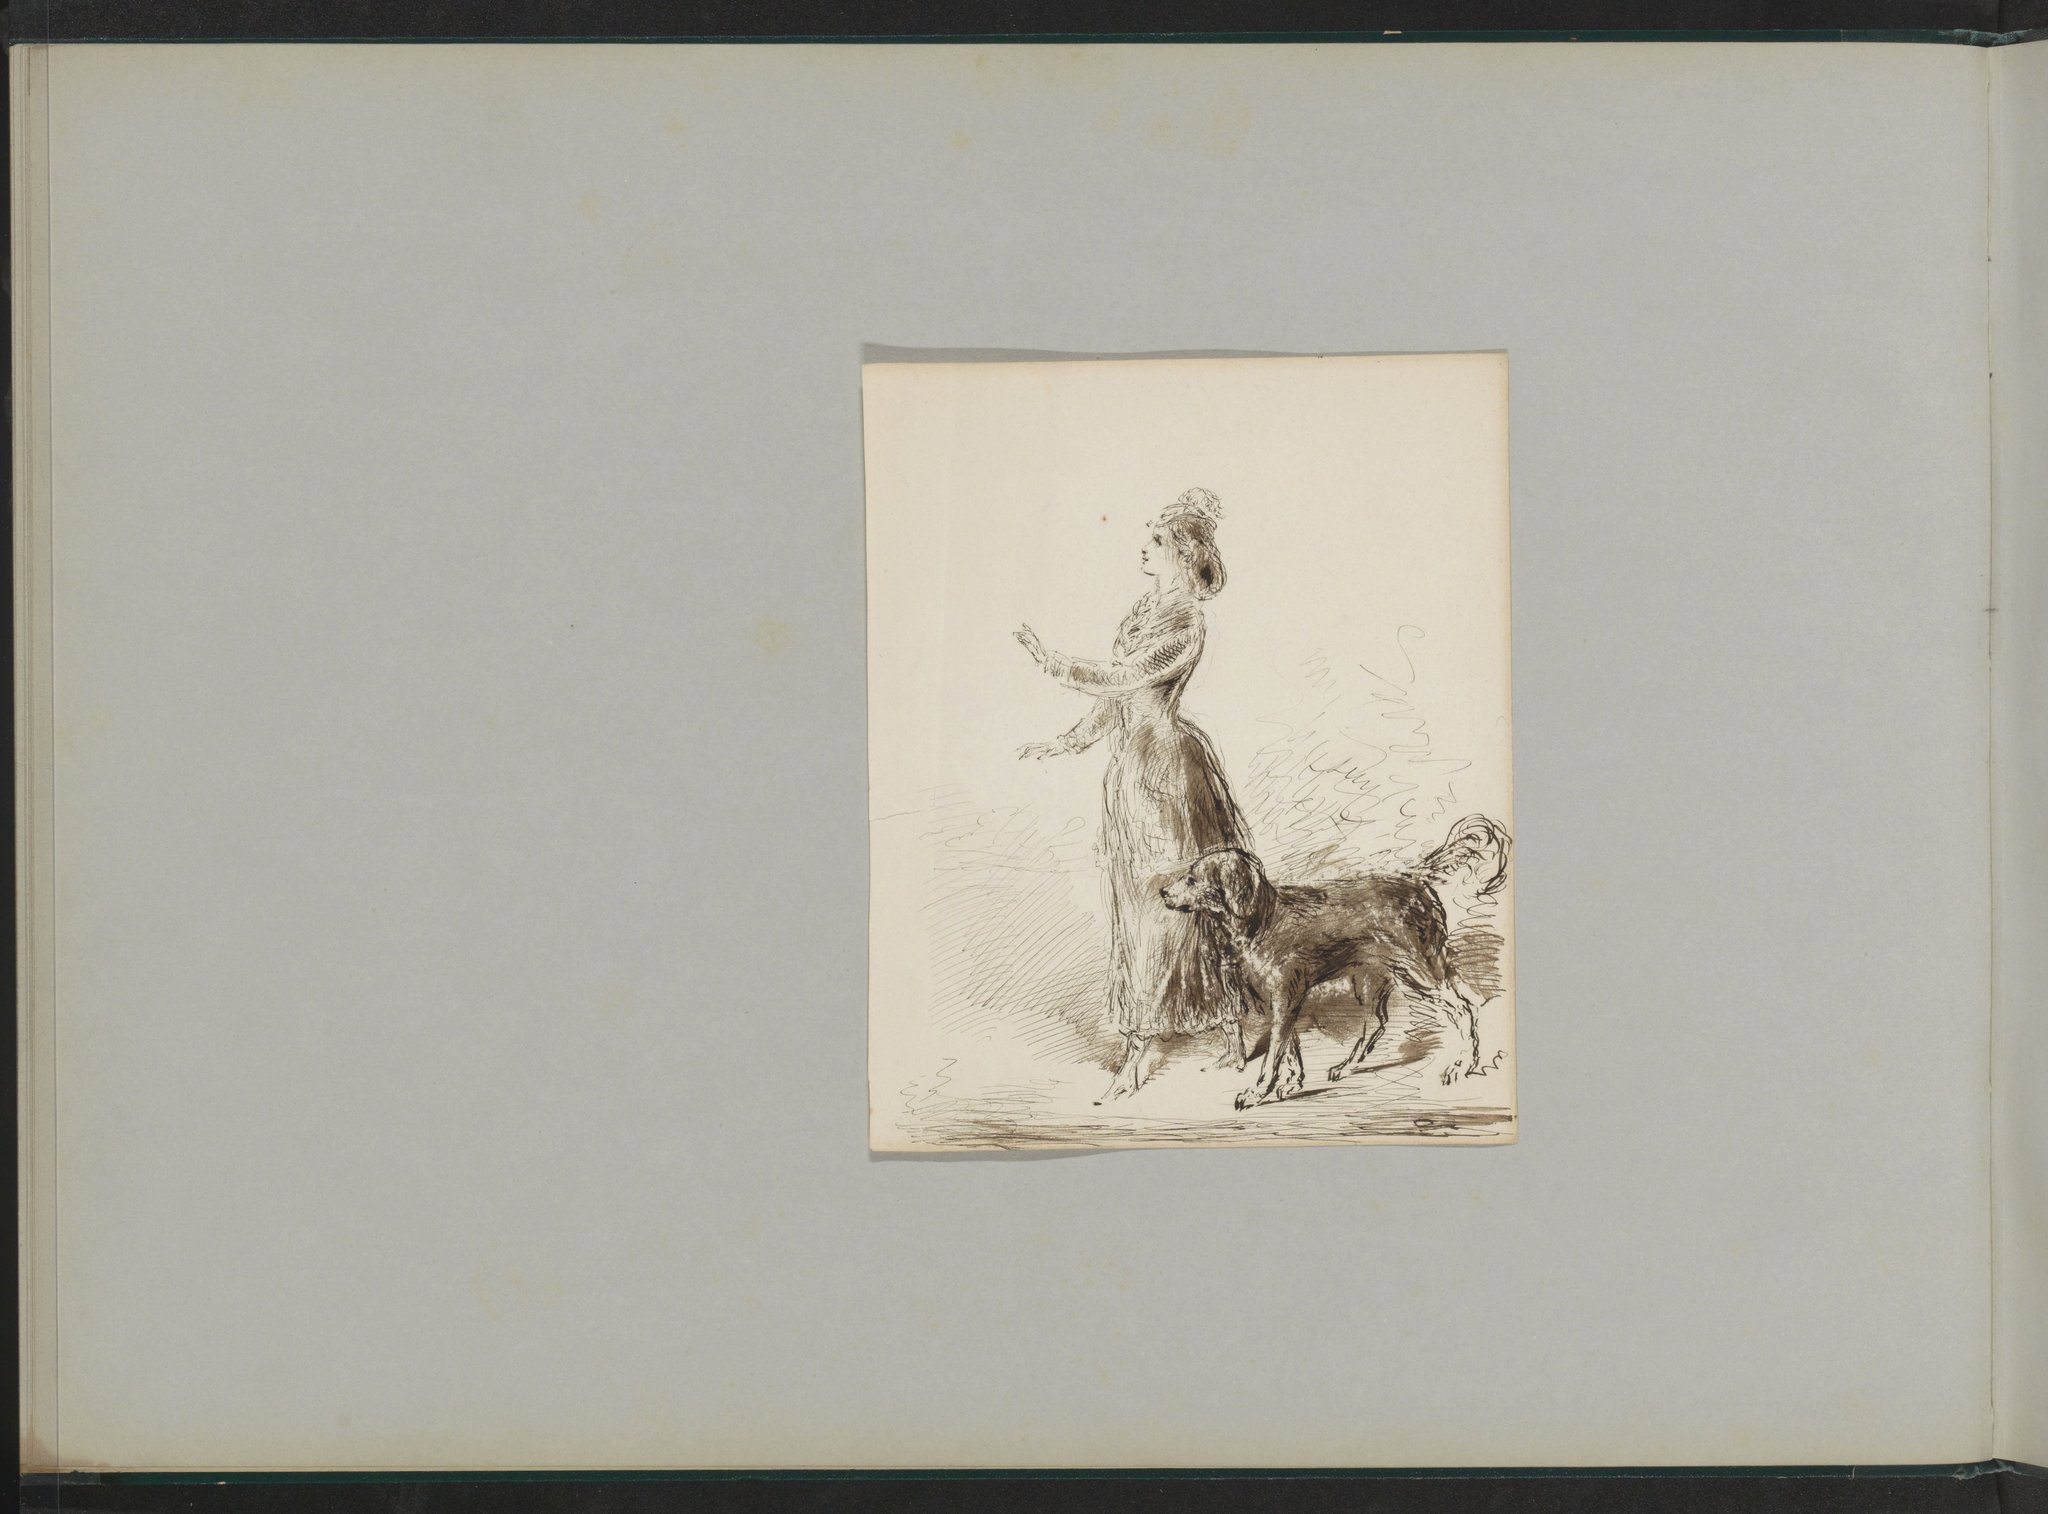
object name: drawing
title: Wandelende vrouw met hond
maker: alexander ver huell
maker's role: draughtsman, print maker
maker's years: 1822-1897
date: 1854-1887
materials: ink, paper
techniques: brush, pen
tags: walking the dog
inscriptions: signature: ‘Avh’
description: Losse tekening tussen blad 11 en 12 van een album met 35 tekeningen.